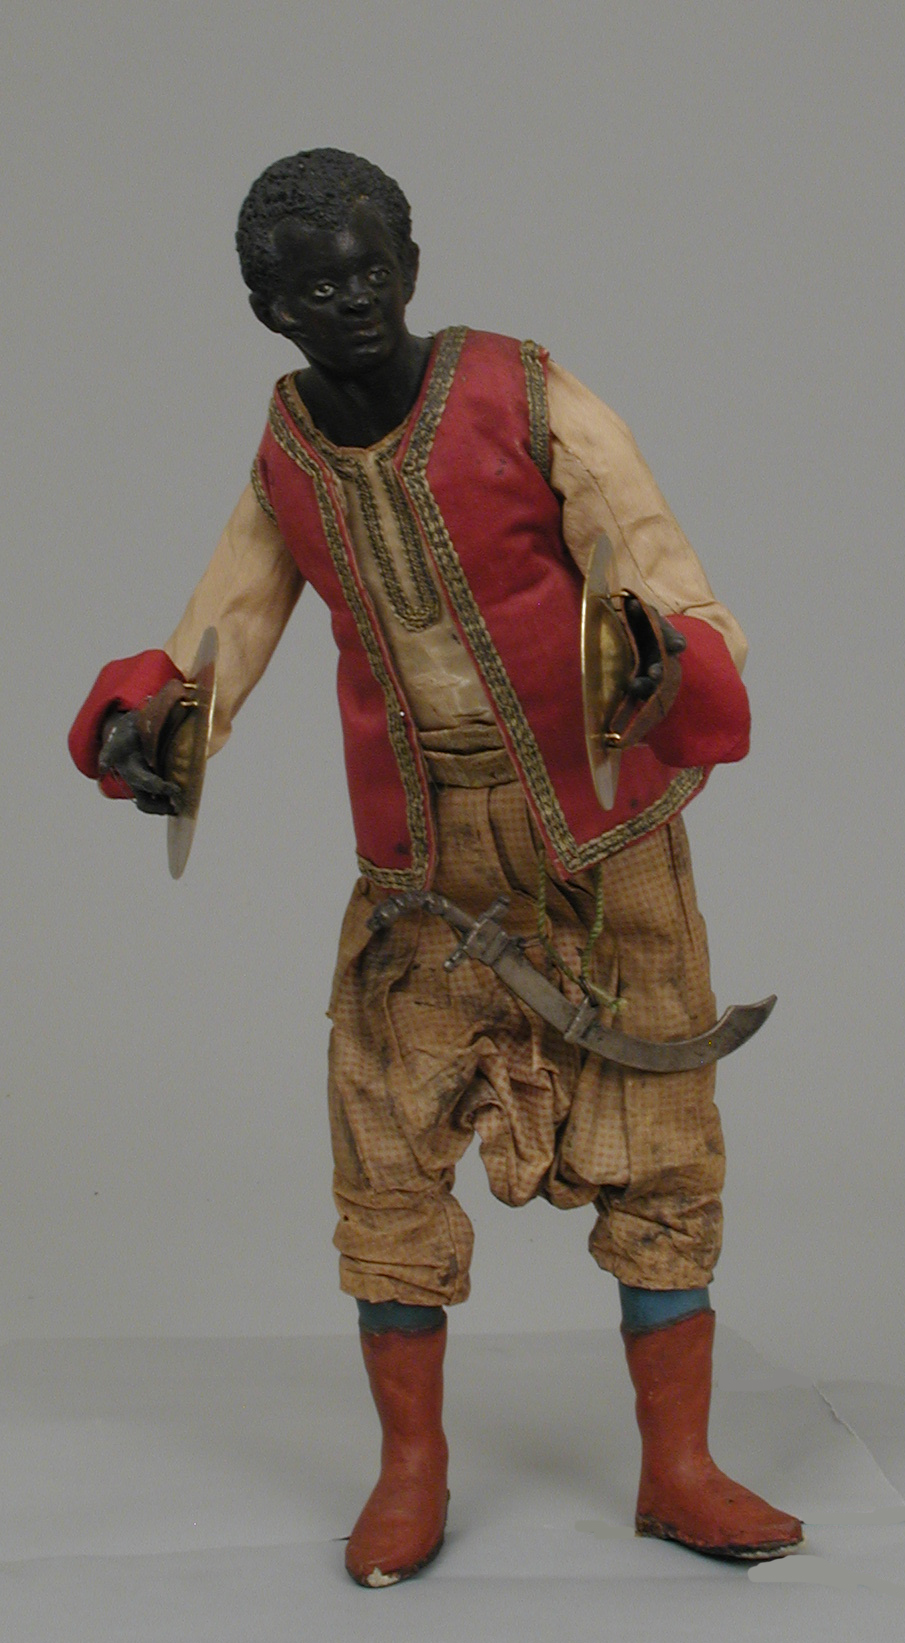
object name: crèche figure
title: Man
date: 1701-1900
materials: terracotta, fiber, metal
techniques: polychrome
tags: men